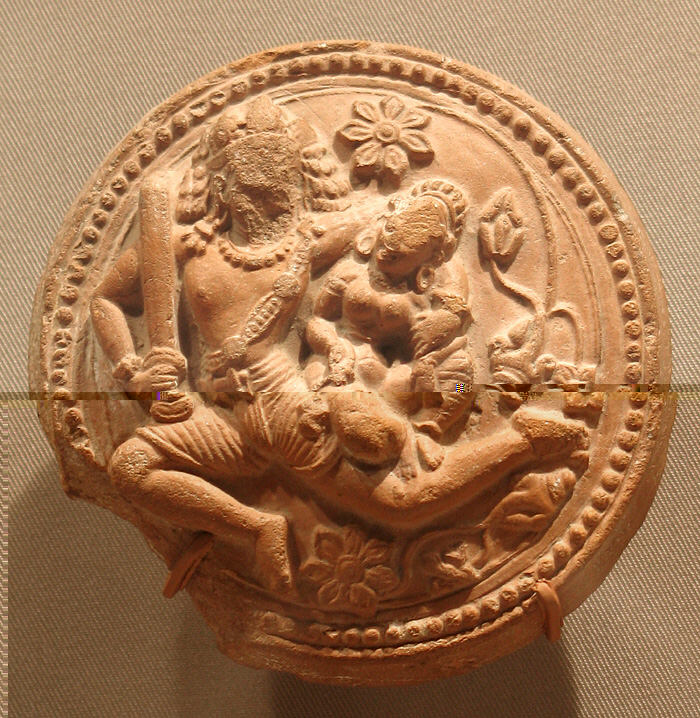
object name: rondel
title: Rondel with a Racing Male Deity Cradling His Consort (Probably Shiva and Parvati)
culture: indian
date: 401-500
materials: terracotta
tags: gupta,parvati,shiva,hinduism